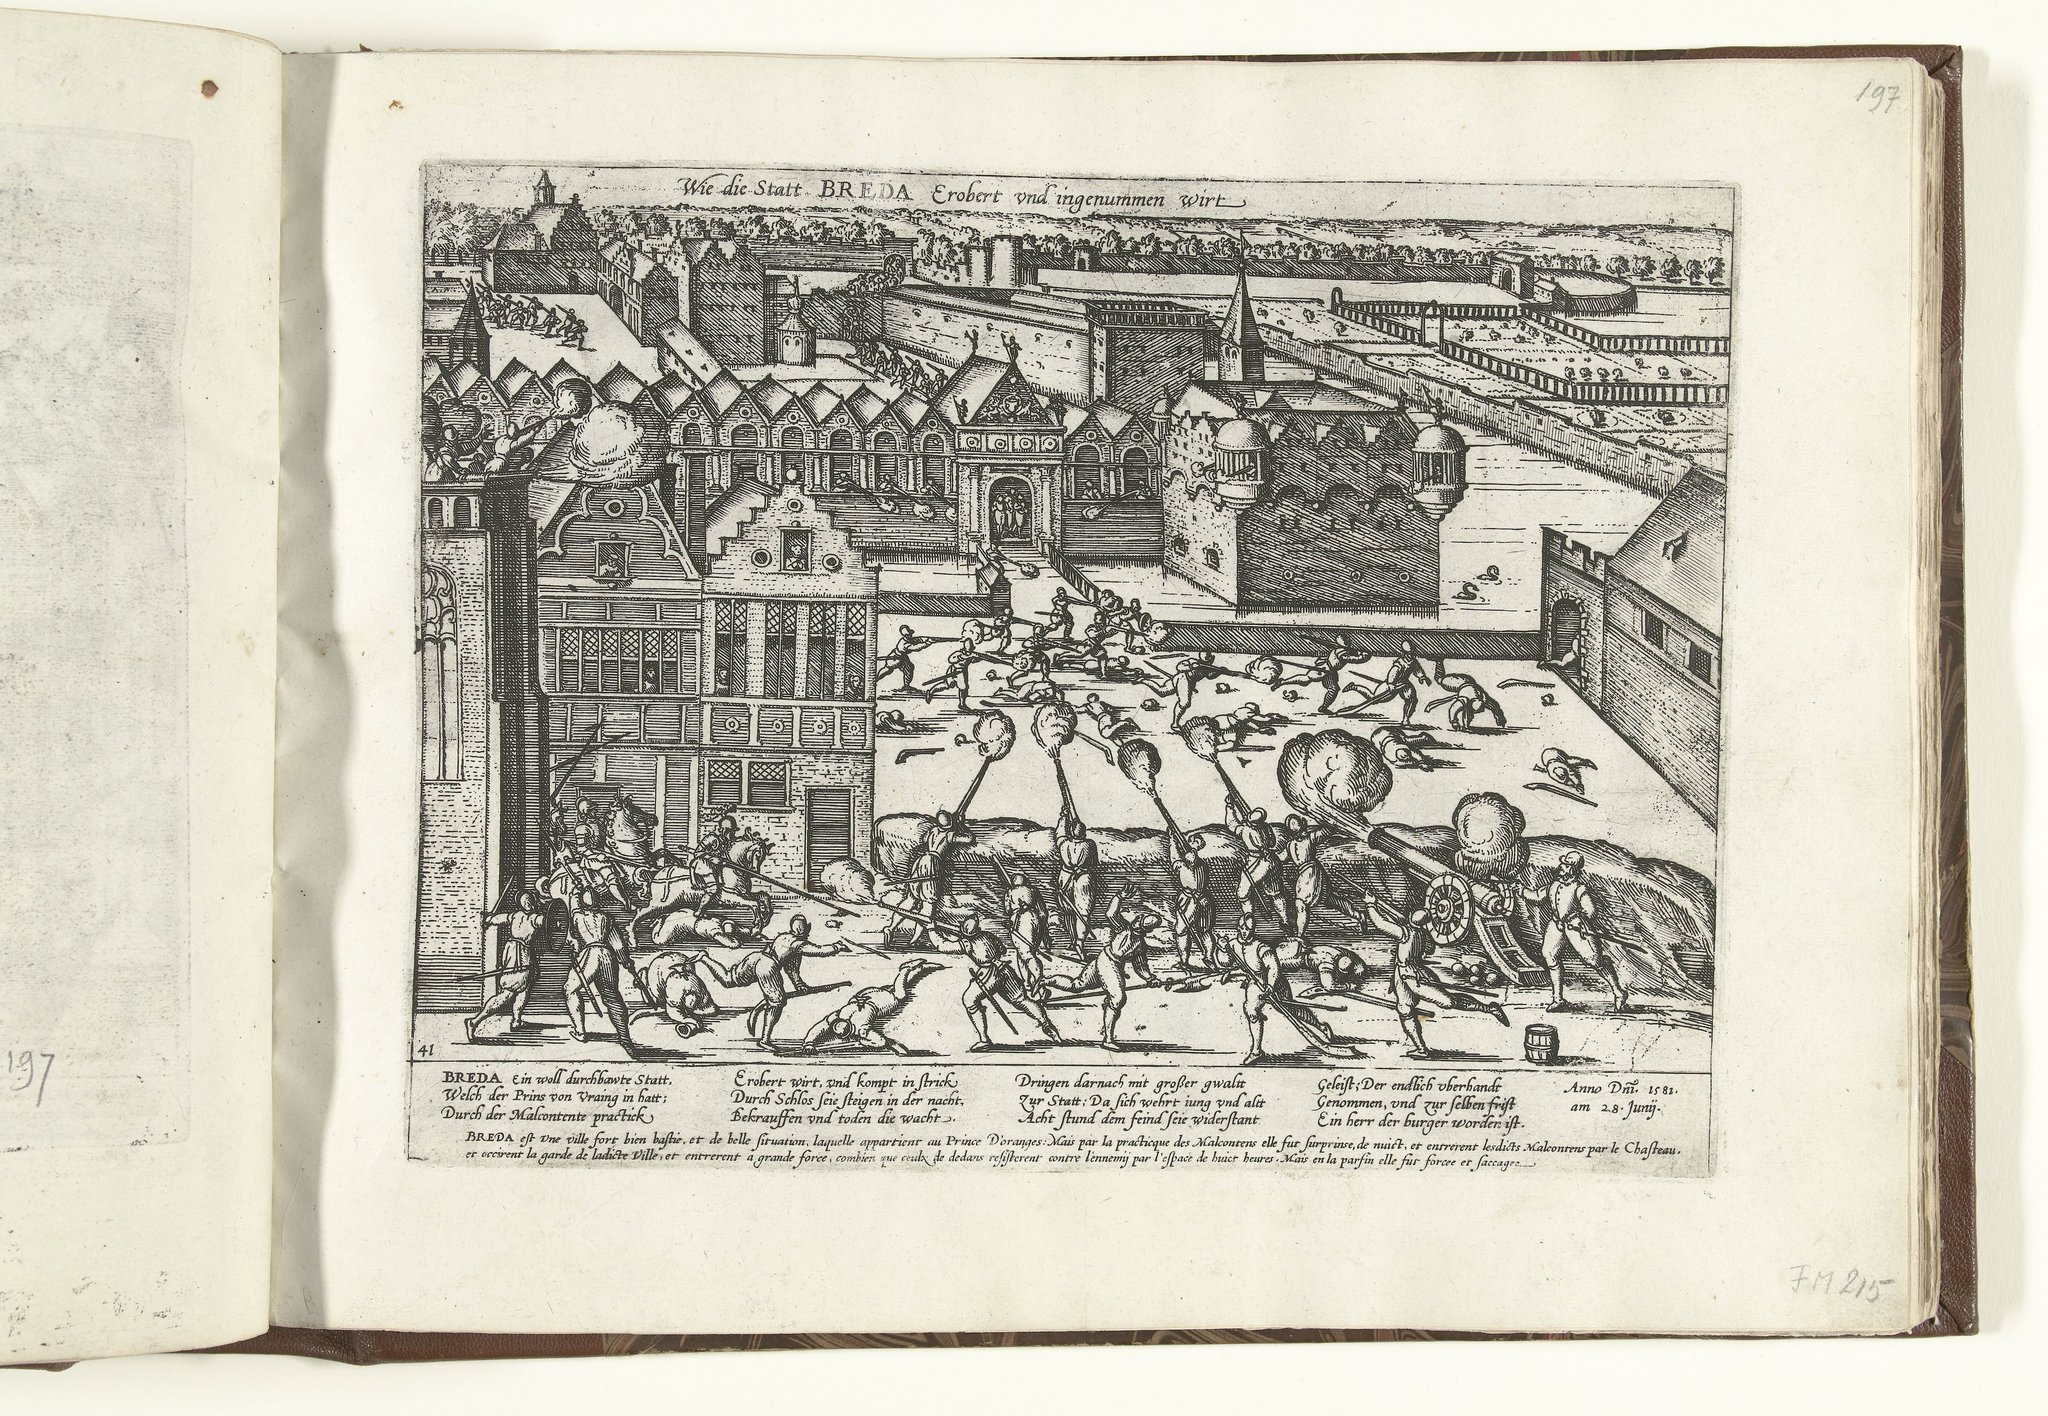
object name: album leaf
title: Serie 8: Nederlandse Gebeurtenissen, 1577-1583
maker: frans hogenberg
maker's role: print maker, publisher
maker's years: 1538-1590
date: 1581-1583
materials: paper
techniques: etching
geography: cologne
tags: capture of city (after the siege)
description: Verovering van Breda door de Malcontenten onder Haultepenne, 18 juni 1581. Met een list wordt het kasteel veroverd en van daaruit de rest van de stad. Op de voorgrond schermutselingen tussen de Spanjaarden en de verdedigers van de stad. Met onderschrift van 12 regels in het Duits en 2 regels in het Frans. Genummerd: 41.